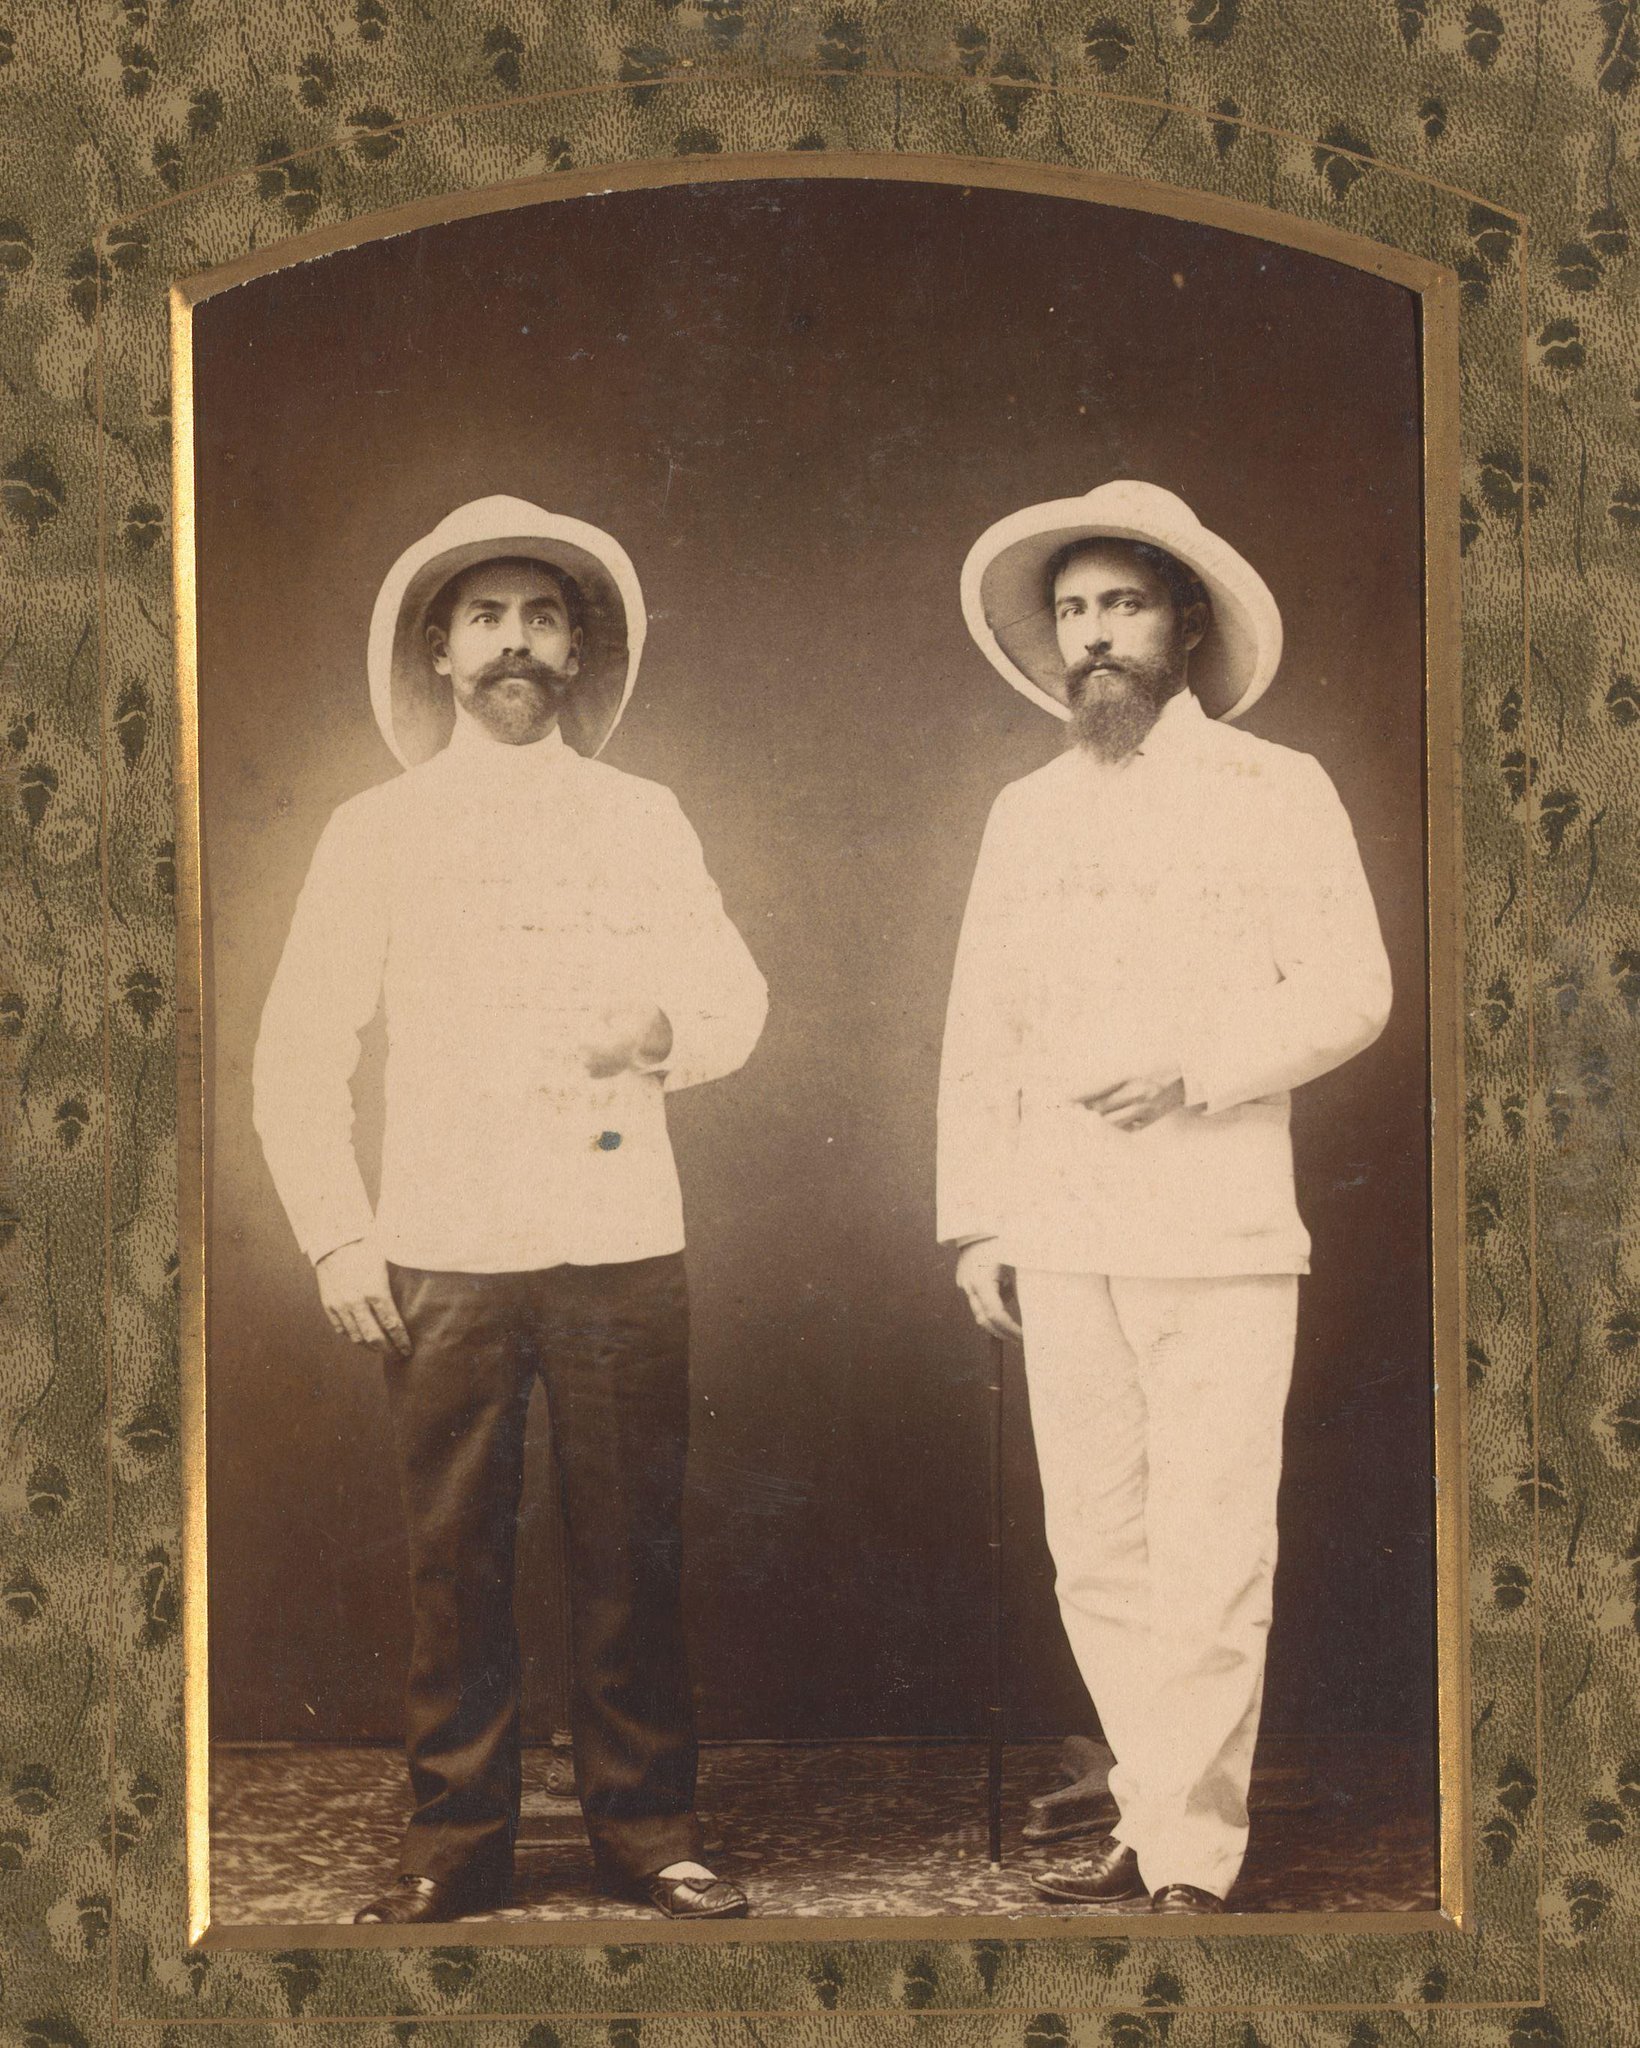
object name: album leaf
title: Portret van twee mannen met snor en baard in tropenkostuum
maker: mi cheong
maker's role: fotograaf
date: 1850-1900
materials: cardboard, photographic support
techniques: albumen print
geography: indo-china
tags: historical persons, tropical culture, beard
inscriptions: inscription: ‘Mi Cheong/ Photographe/ grande rue à côté du marché/ Nai-Phong, (TonKin.)/ (...)’